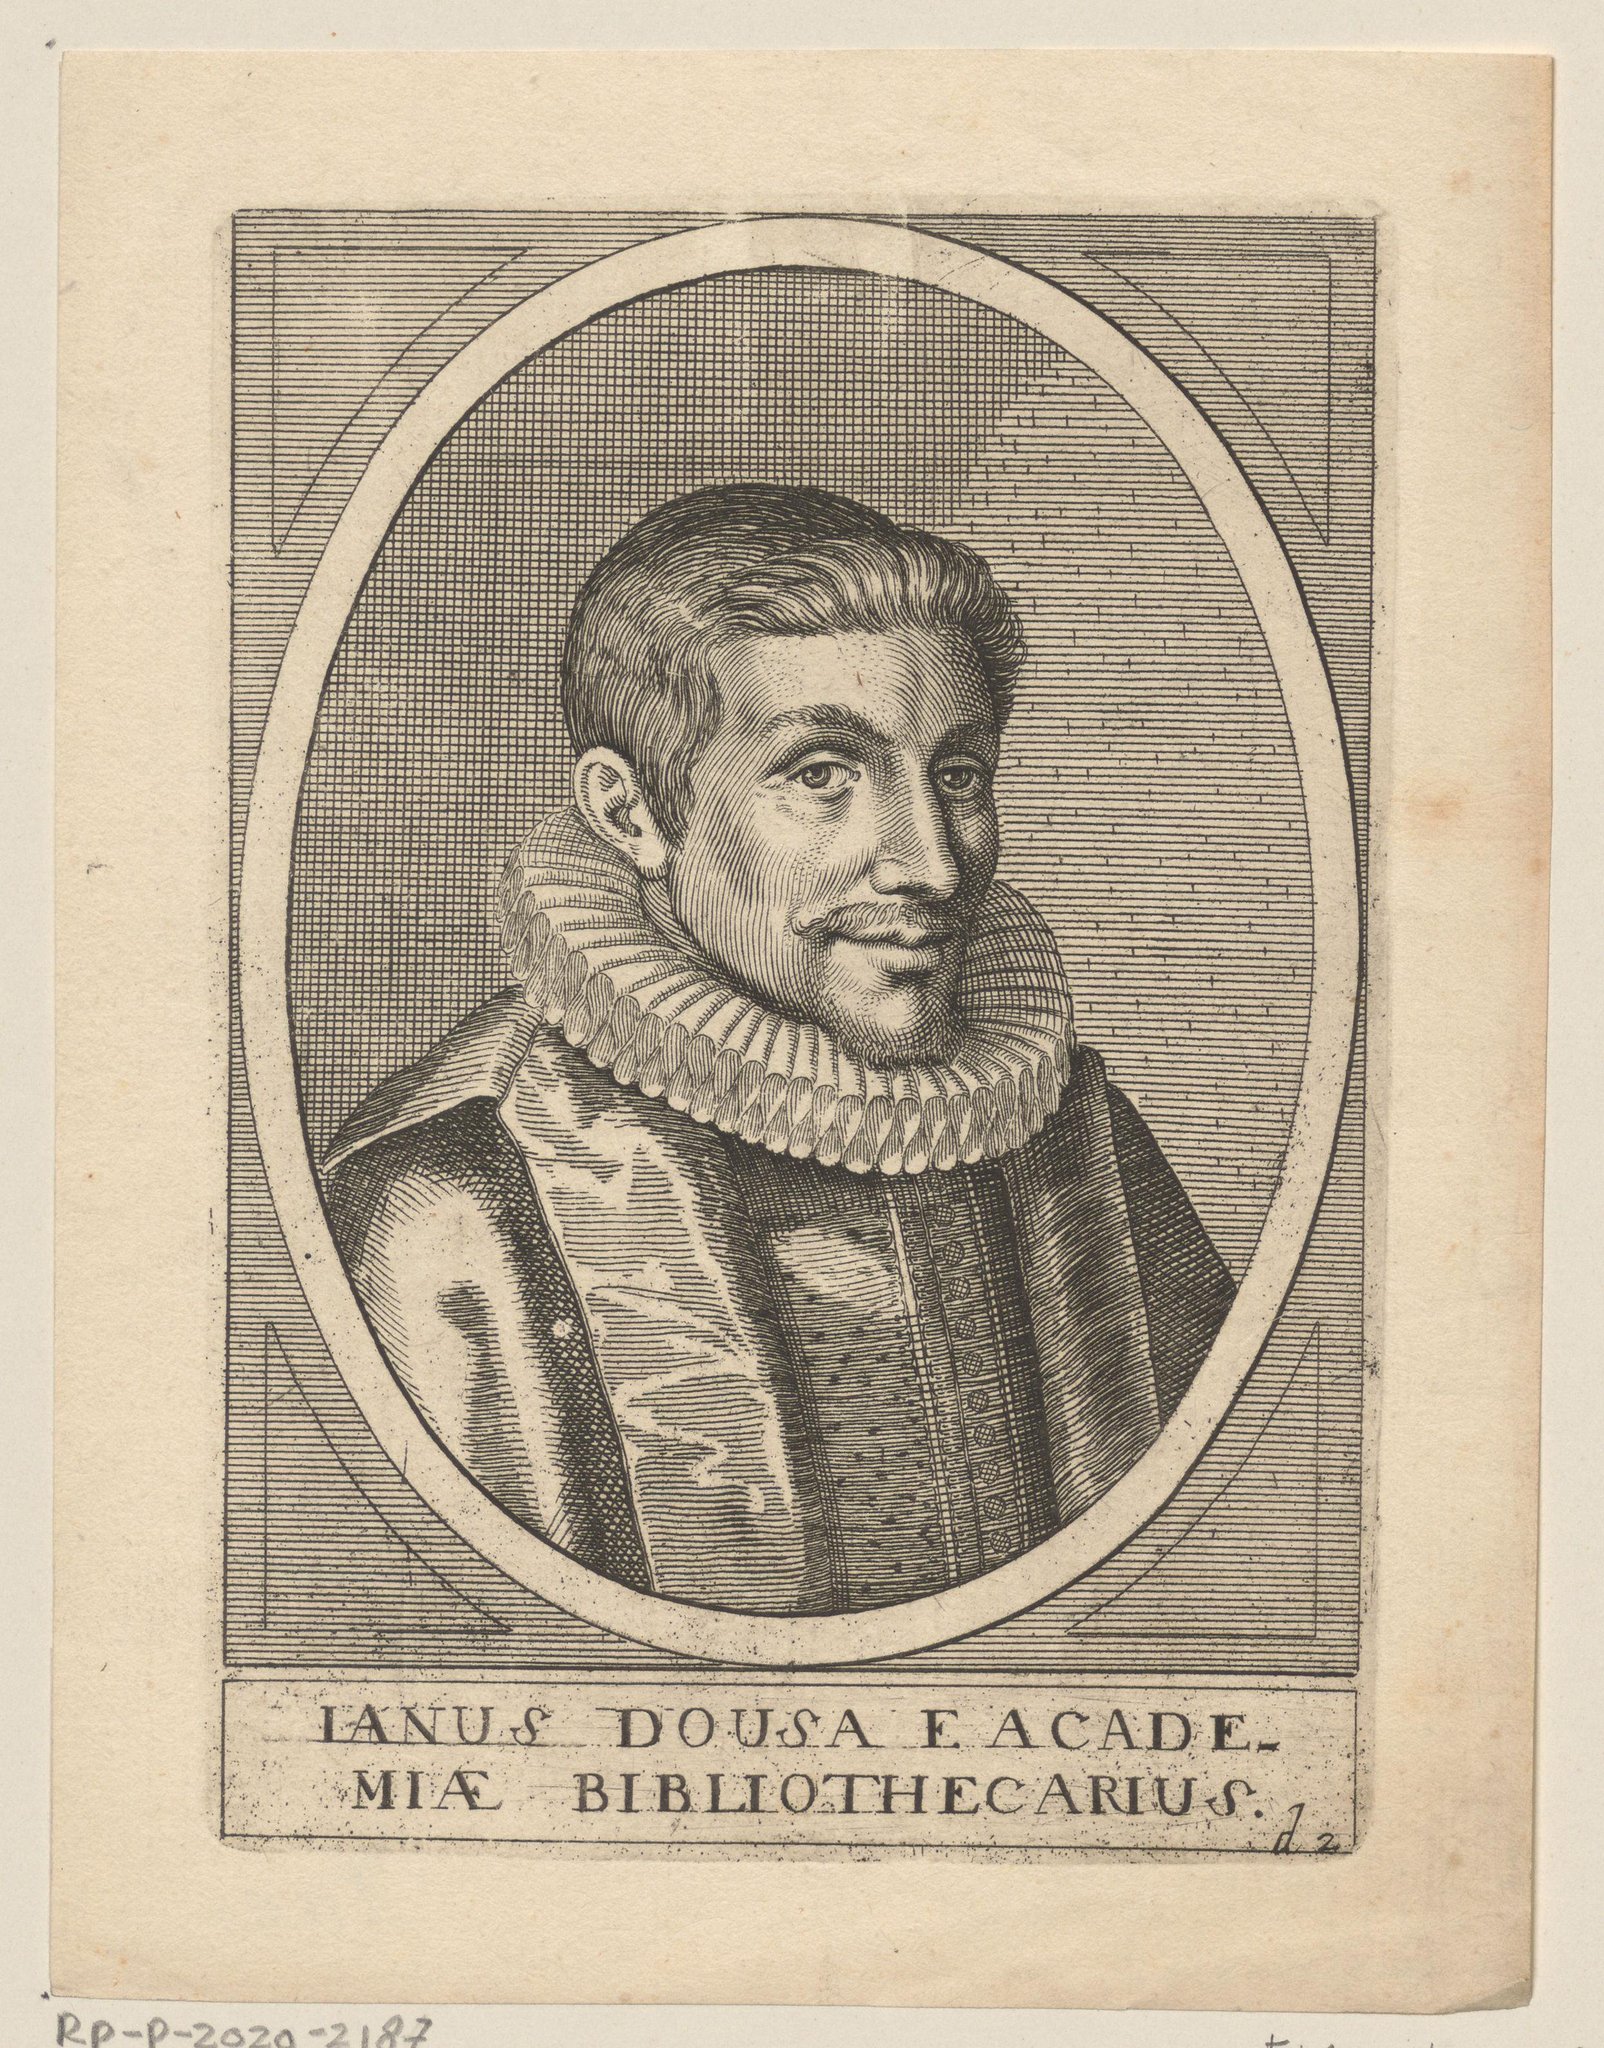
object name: print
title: Portret van Janus Dousa II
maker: sebastian furck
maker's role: print maker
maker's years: 1600-1655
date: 1650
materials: paper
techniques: engraving, etching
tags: the hague, janus dousa (jr.), historical persons, writer, poet, author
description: Prent mogelijk uit: Bibliotheca chalcographica. Heidelberg: Clemens Ammon, 1669. Of uit: Bibliotheca chalcographica. Frankfurt am Main: Johannes Ammon, 1650.